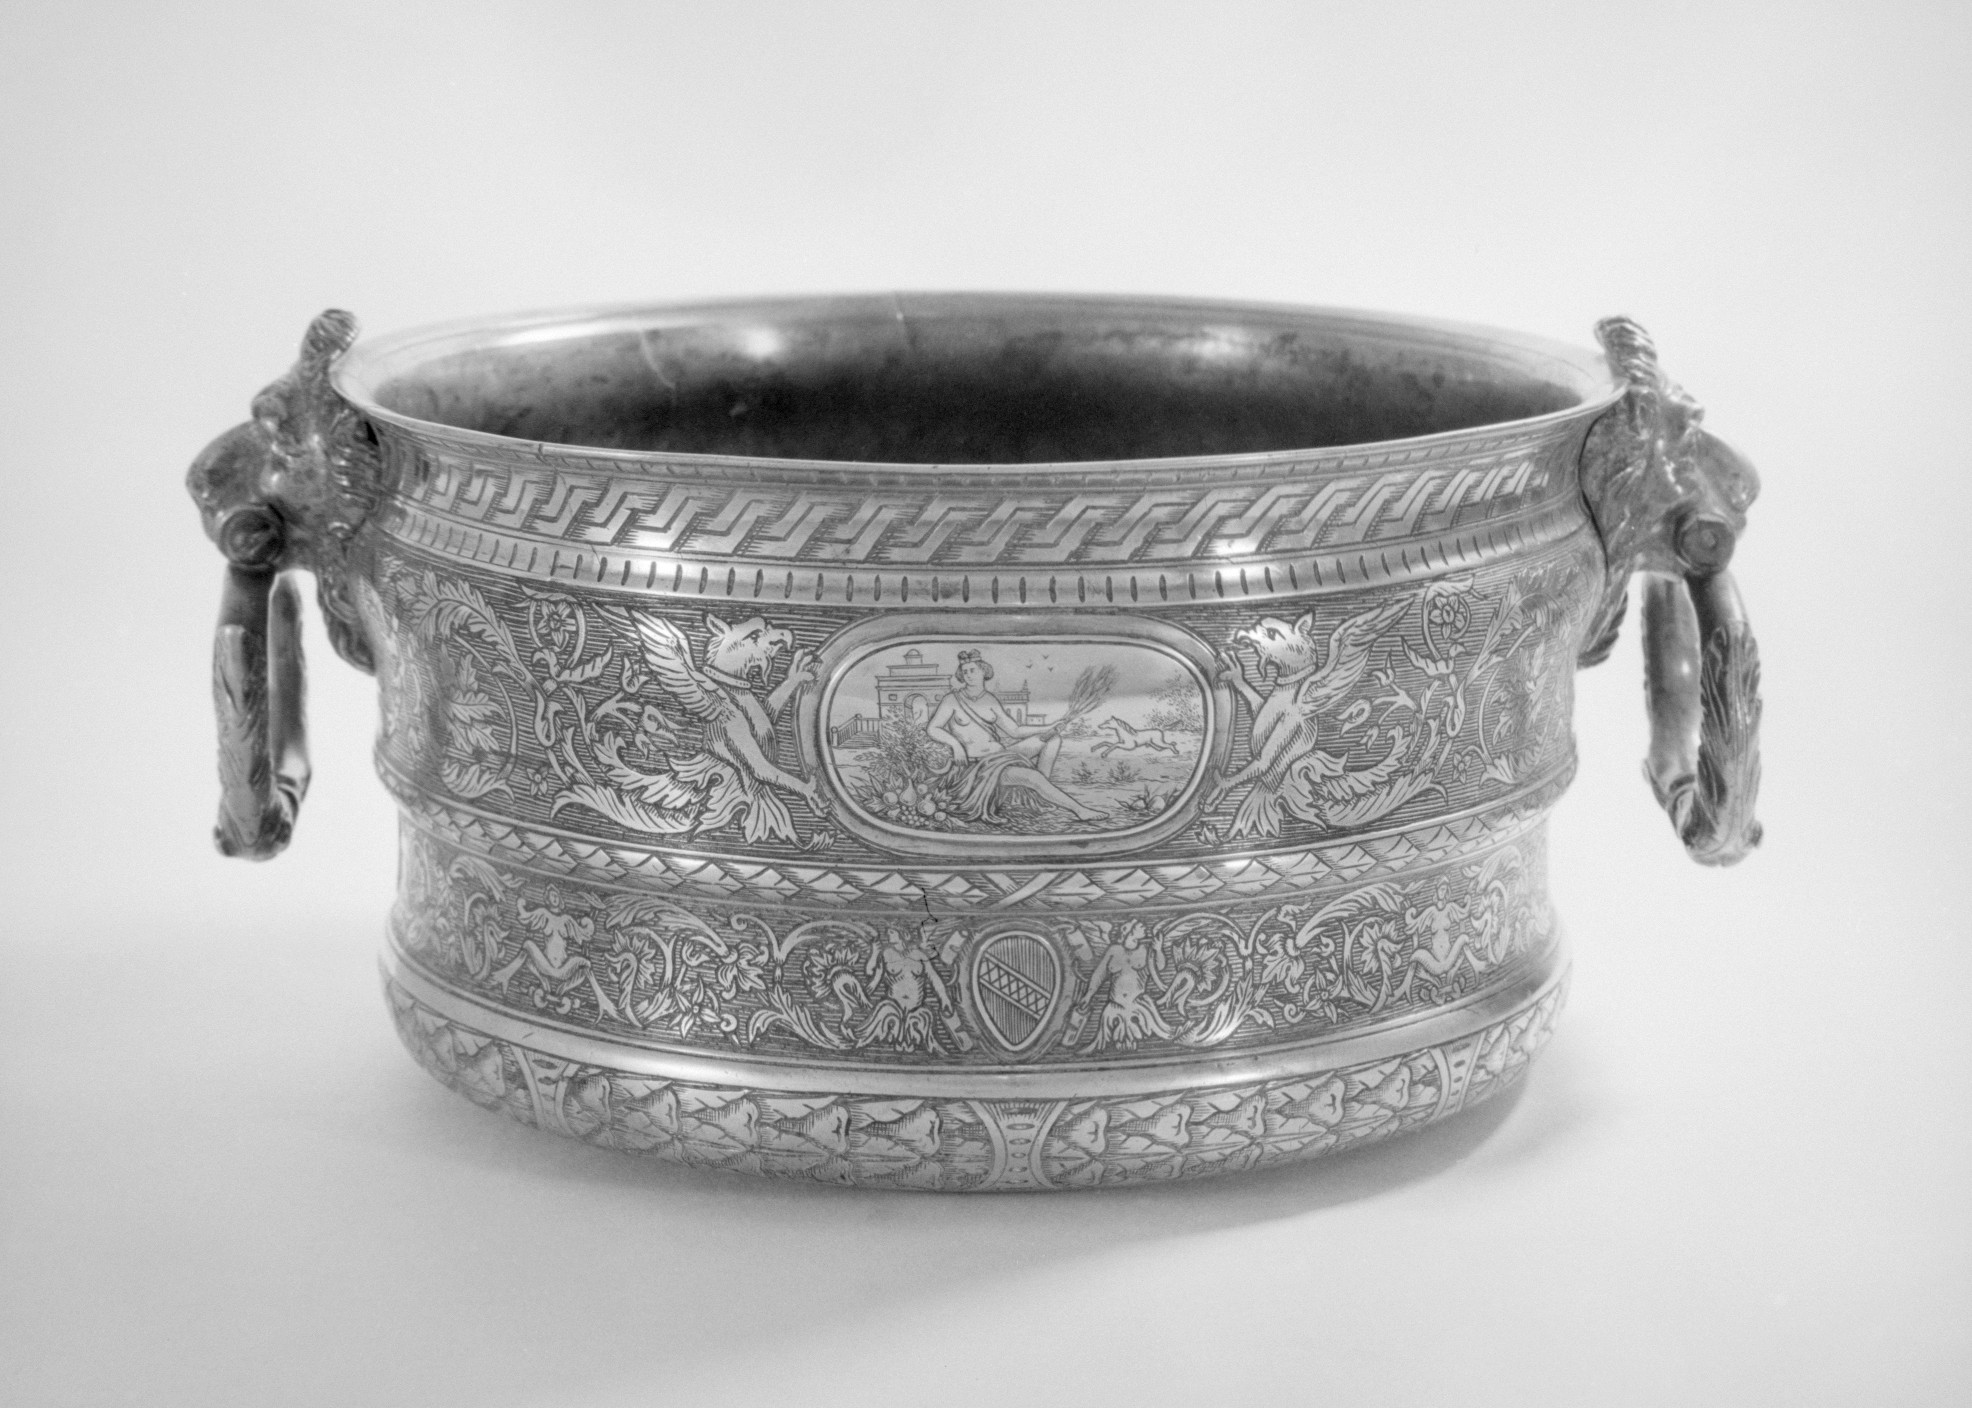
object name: bowl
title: Bowl with two bail handles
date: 1801-1900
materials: brass